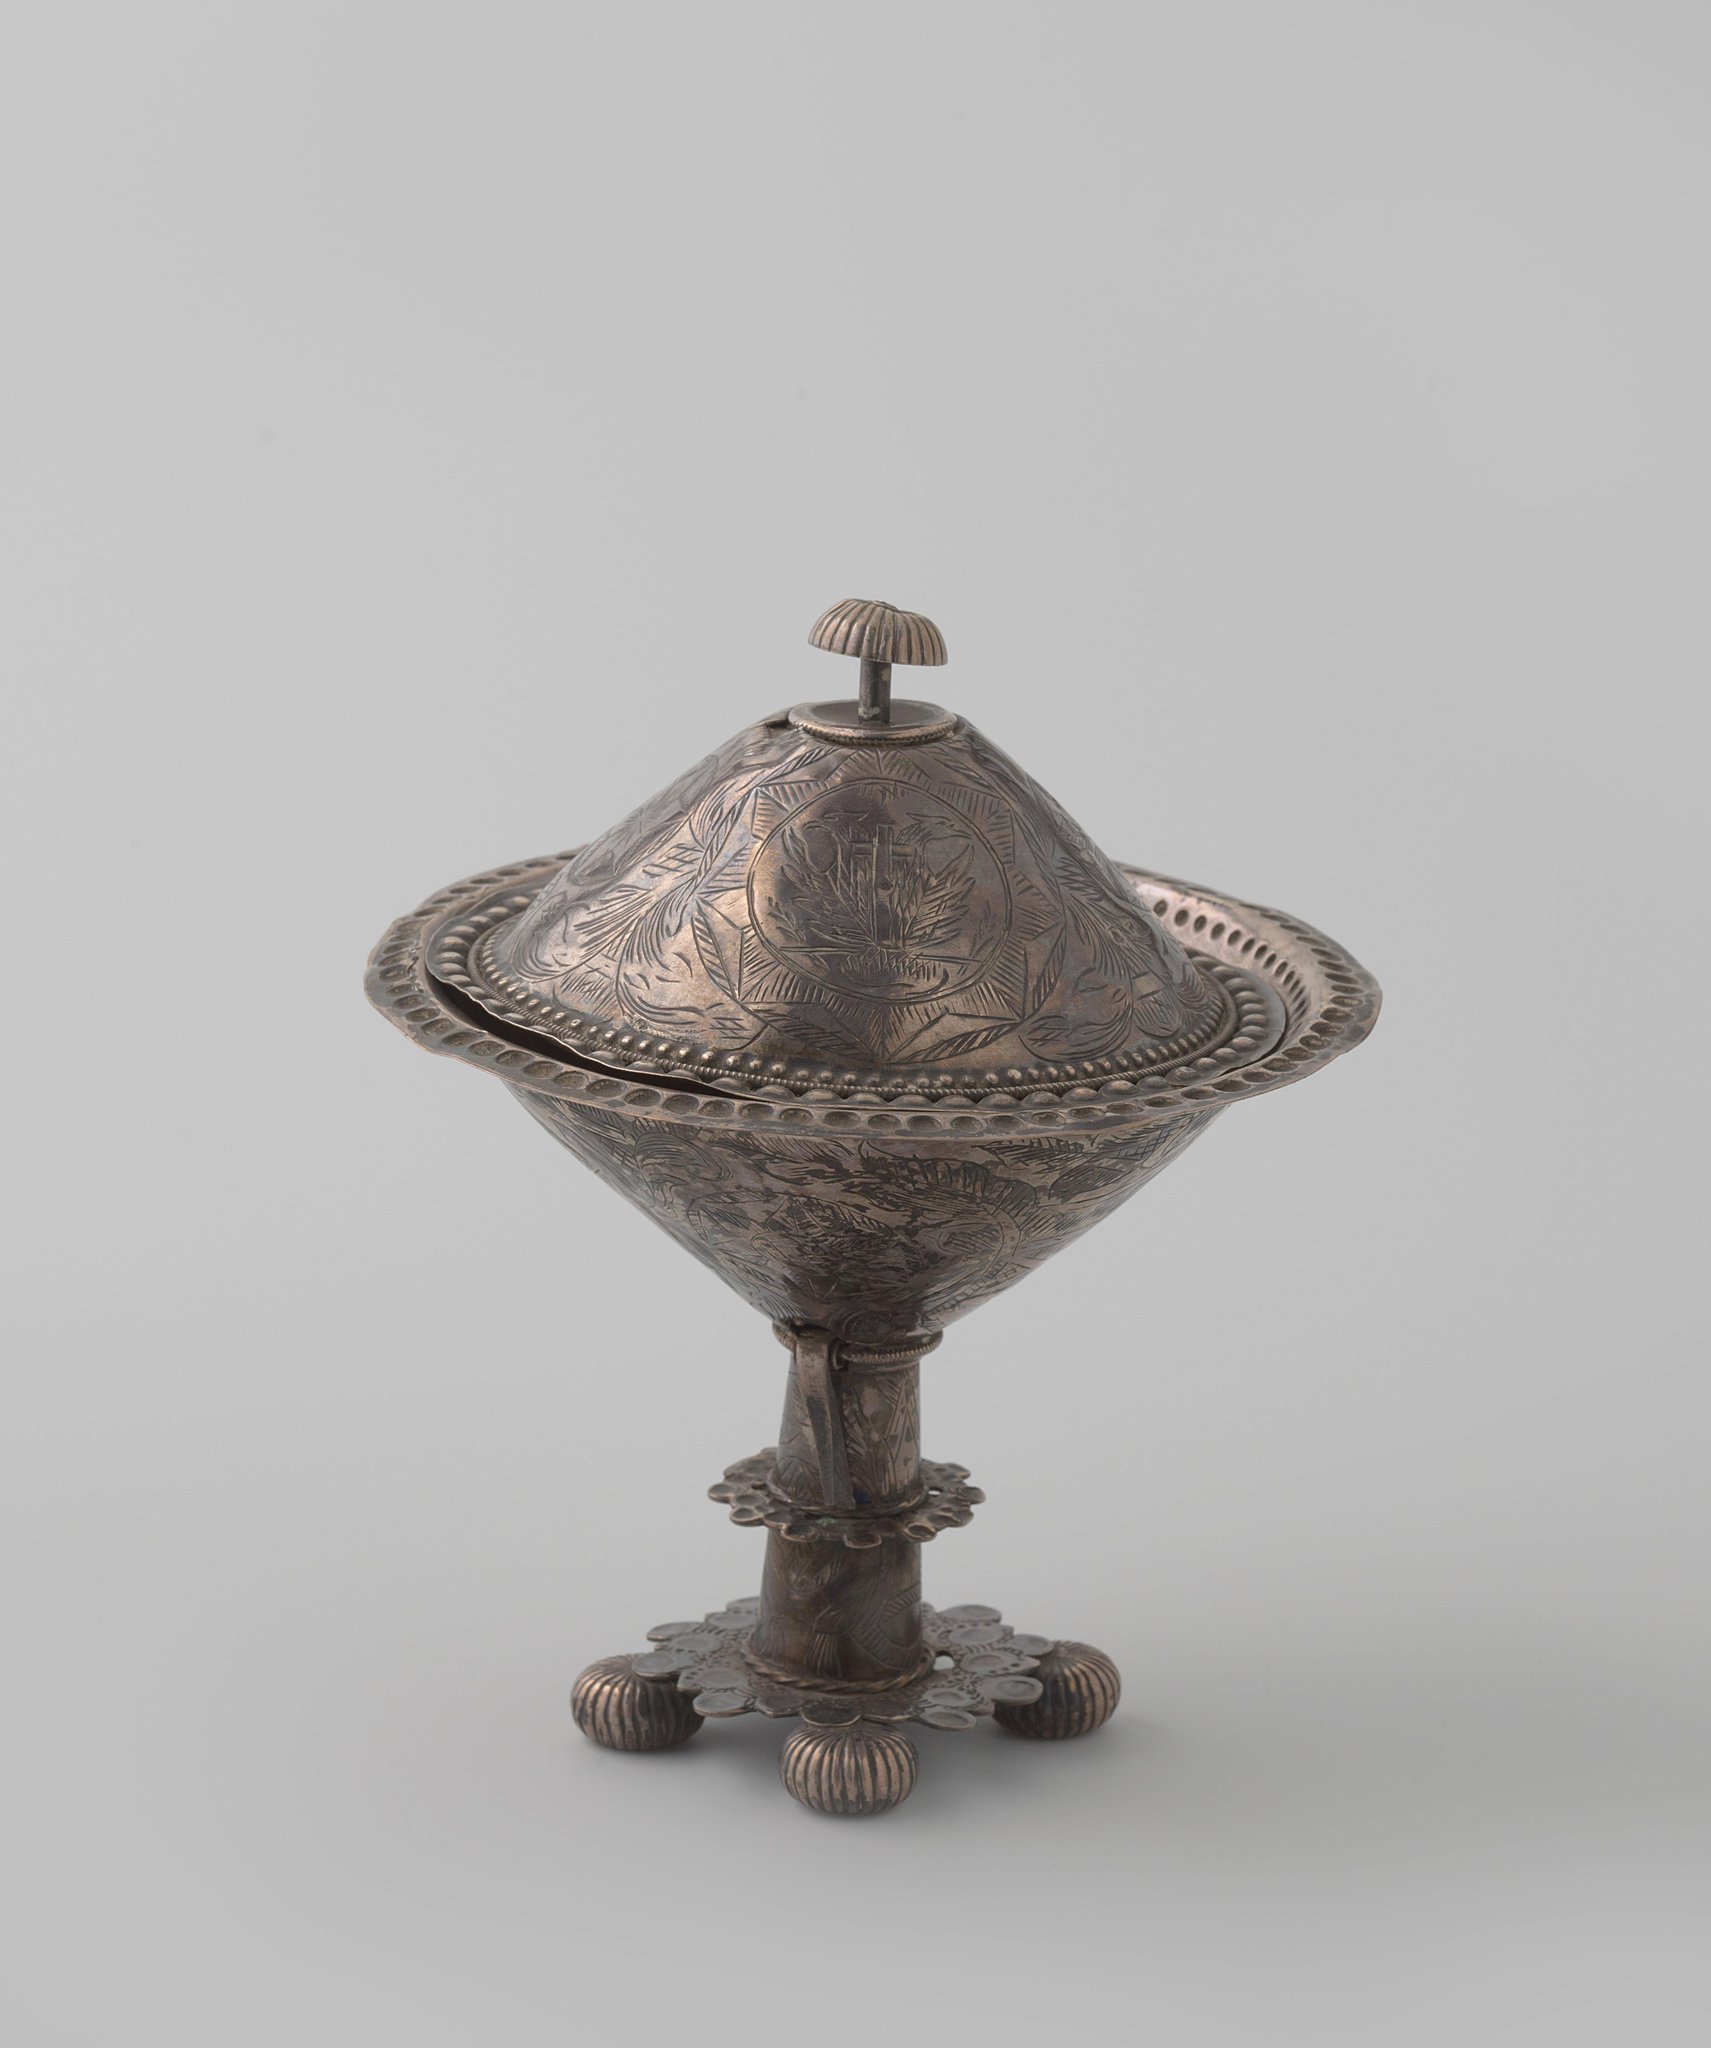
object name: kelk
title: Ciborie van zilver. De kegelvormige cuppa met deksel staat op een conische schacht. Geheel versierd met graveerwerk in blad- en stermotieven.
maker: Anonymous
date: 1500-1600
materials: silver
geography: poland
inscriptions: : ‘Fra u. Renata i/l Pflegepapa Onkel Schiemann’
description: Ciborie van zilver. De kegelvormige cuppa met idem deksel staat op een conische schacht. Geheel versierd met graveerwerk in blad en stermotieven. Meesterteken: RC of RE?